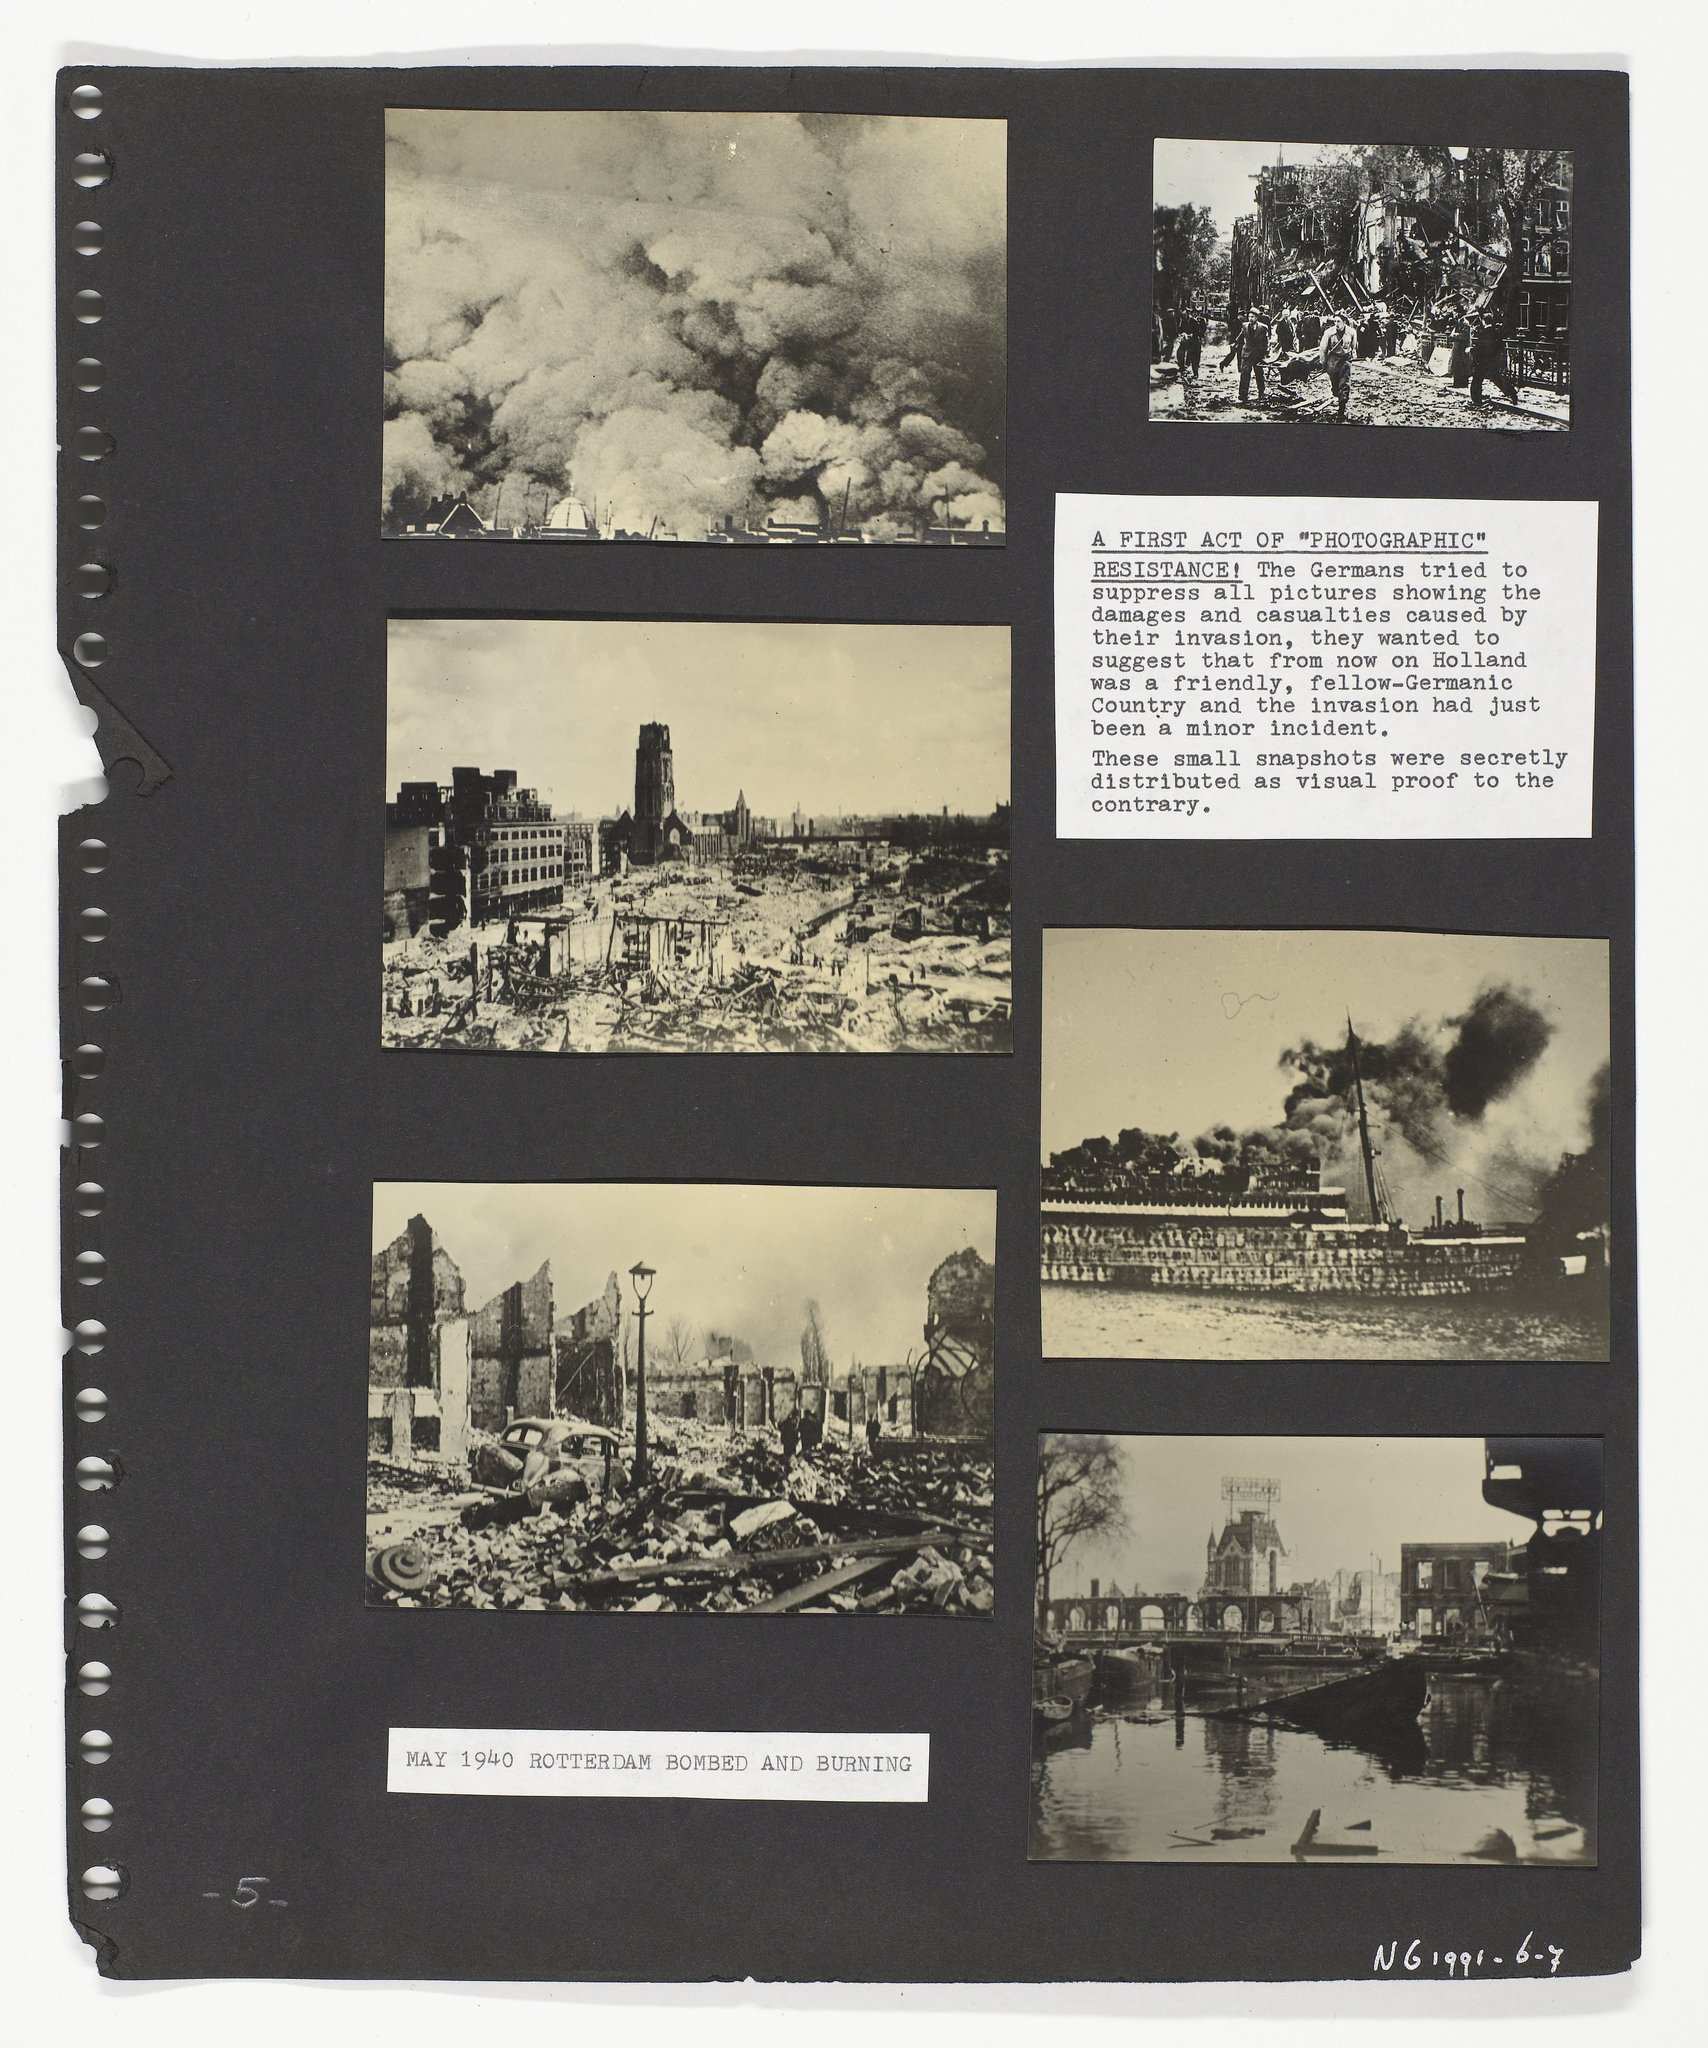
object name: album leaf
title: Foto en collageboek 'De Verborgen Camera'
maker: Anonymous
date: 1905-1940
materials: paper, plastic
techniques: photography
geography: rotterdam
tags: amsterdam, tonny van renterghem, berlin, fritz kahlenberg, devastated, ruined place or city (~ warfare), rotterdam, rotterdam blitz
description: Zes foto's van het gebombardeerde Rotterdam, illegaal verspreid omdat de Duitse bezetter trachtte te verhinderen dat dit soort beelden naar buiten kwamen.